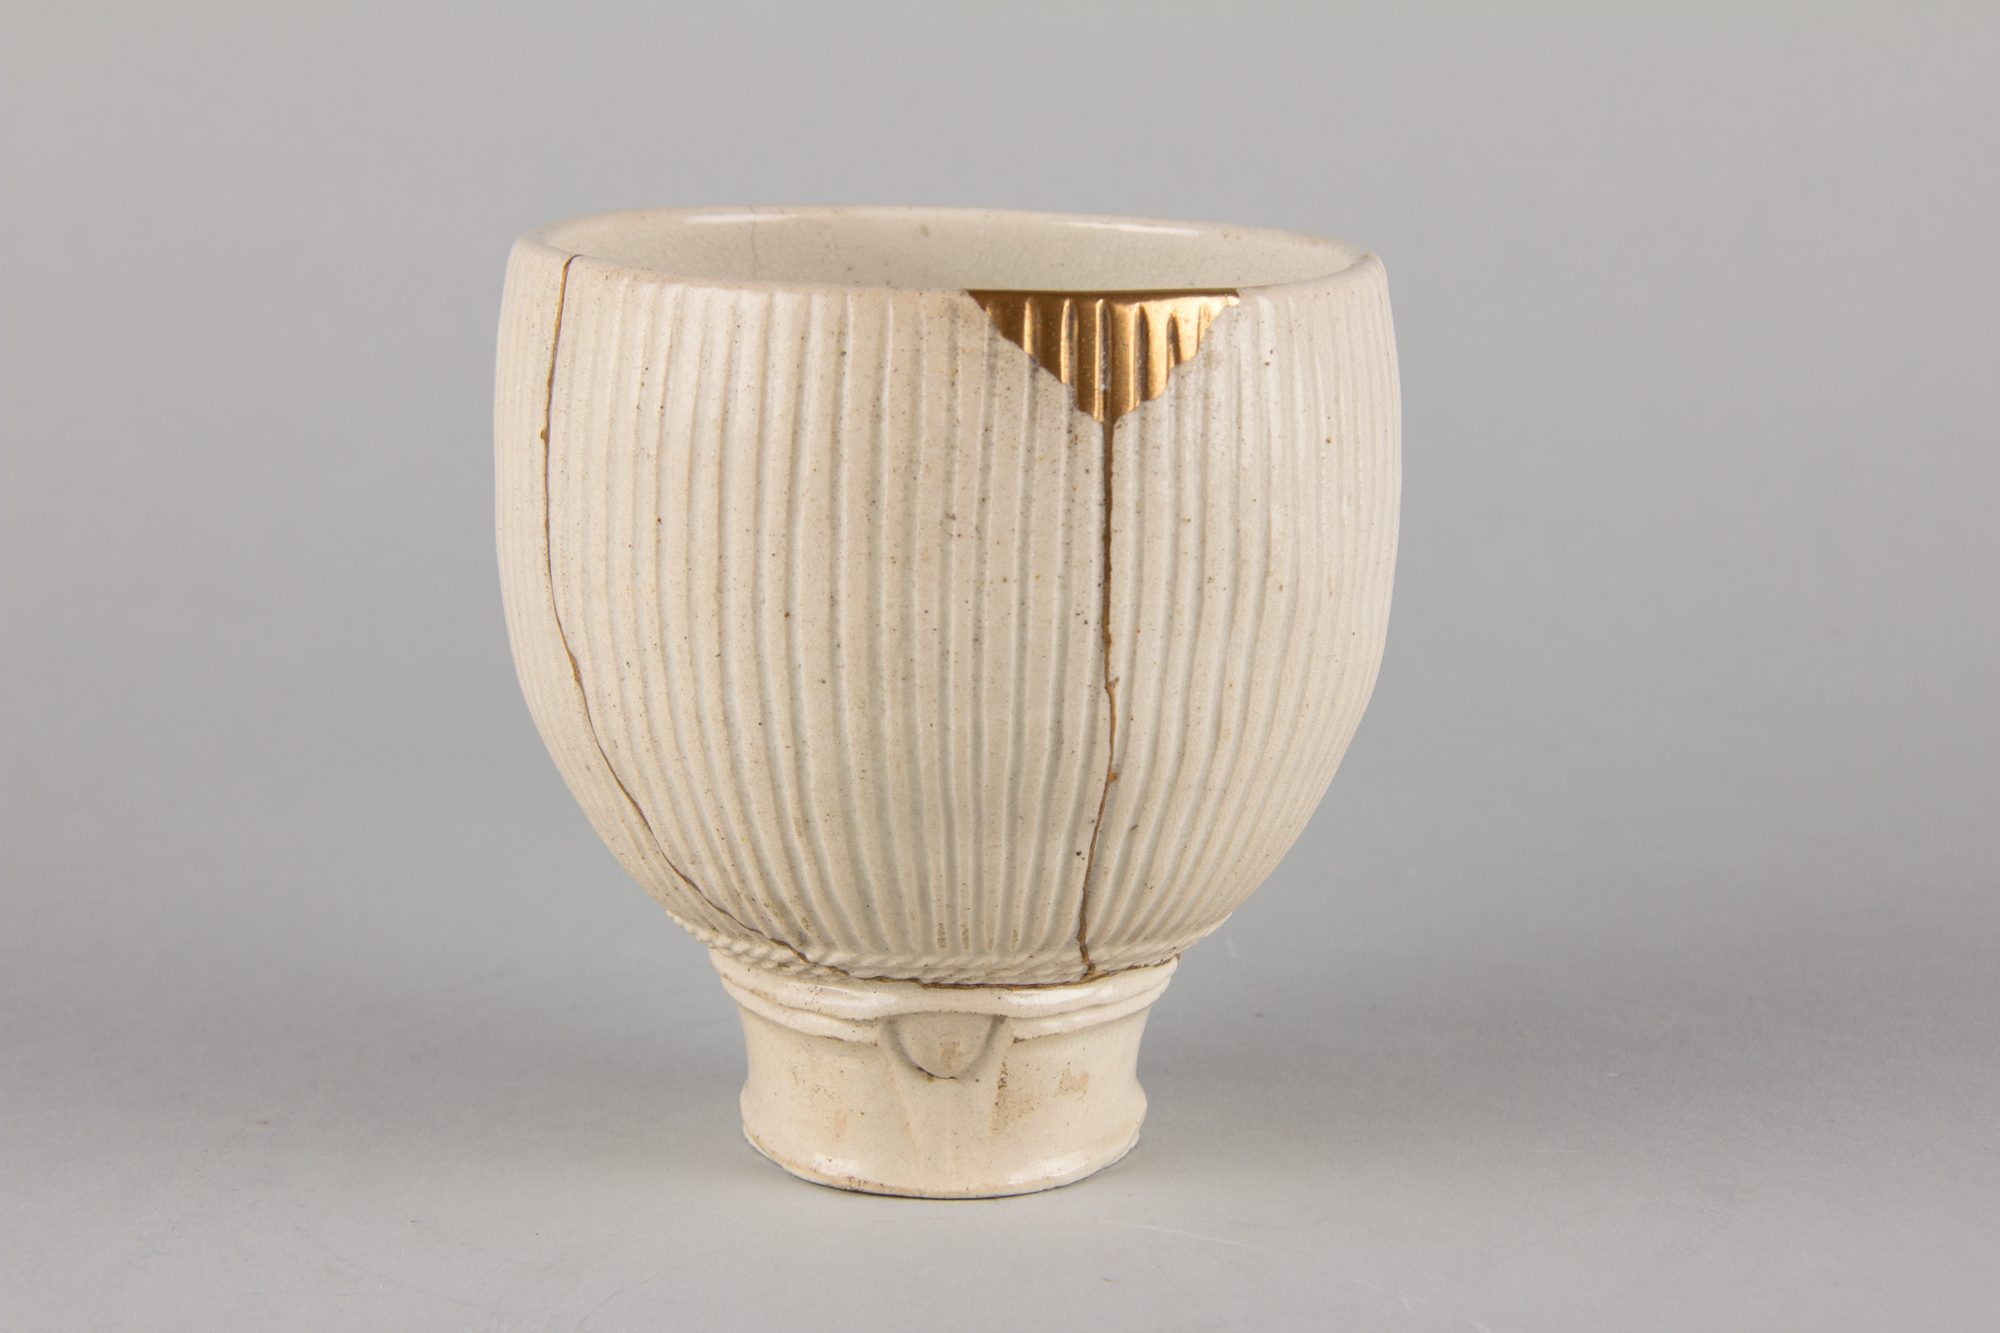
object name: teabowl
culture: japanese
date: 1701-1800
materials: clay, glaze